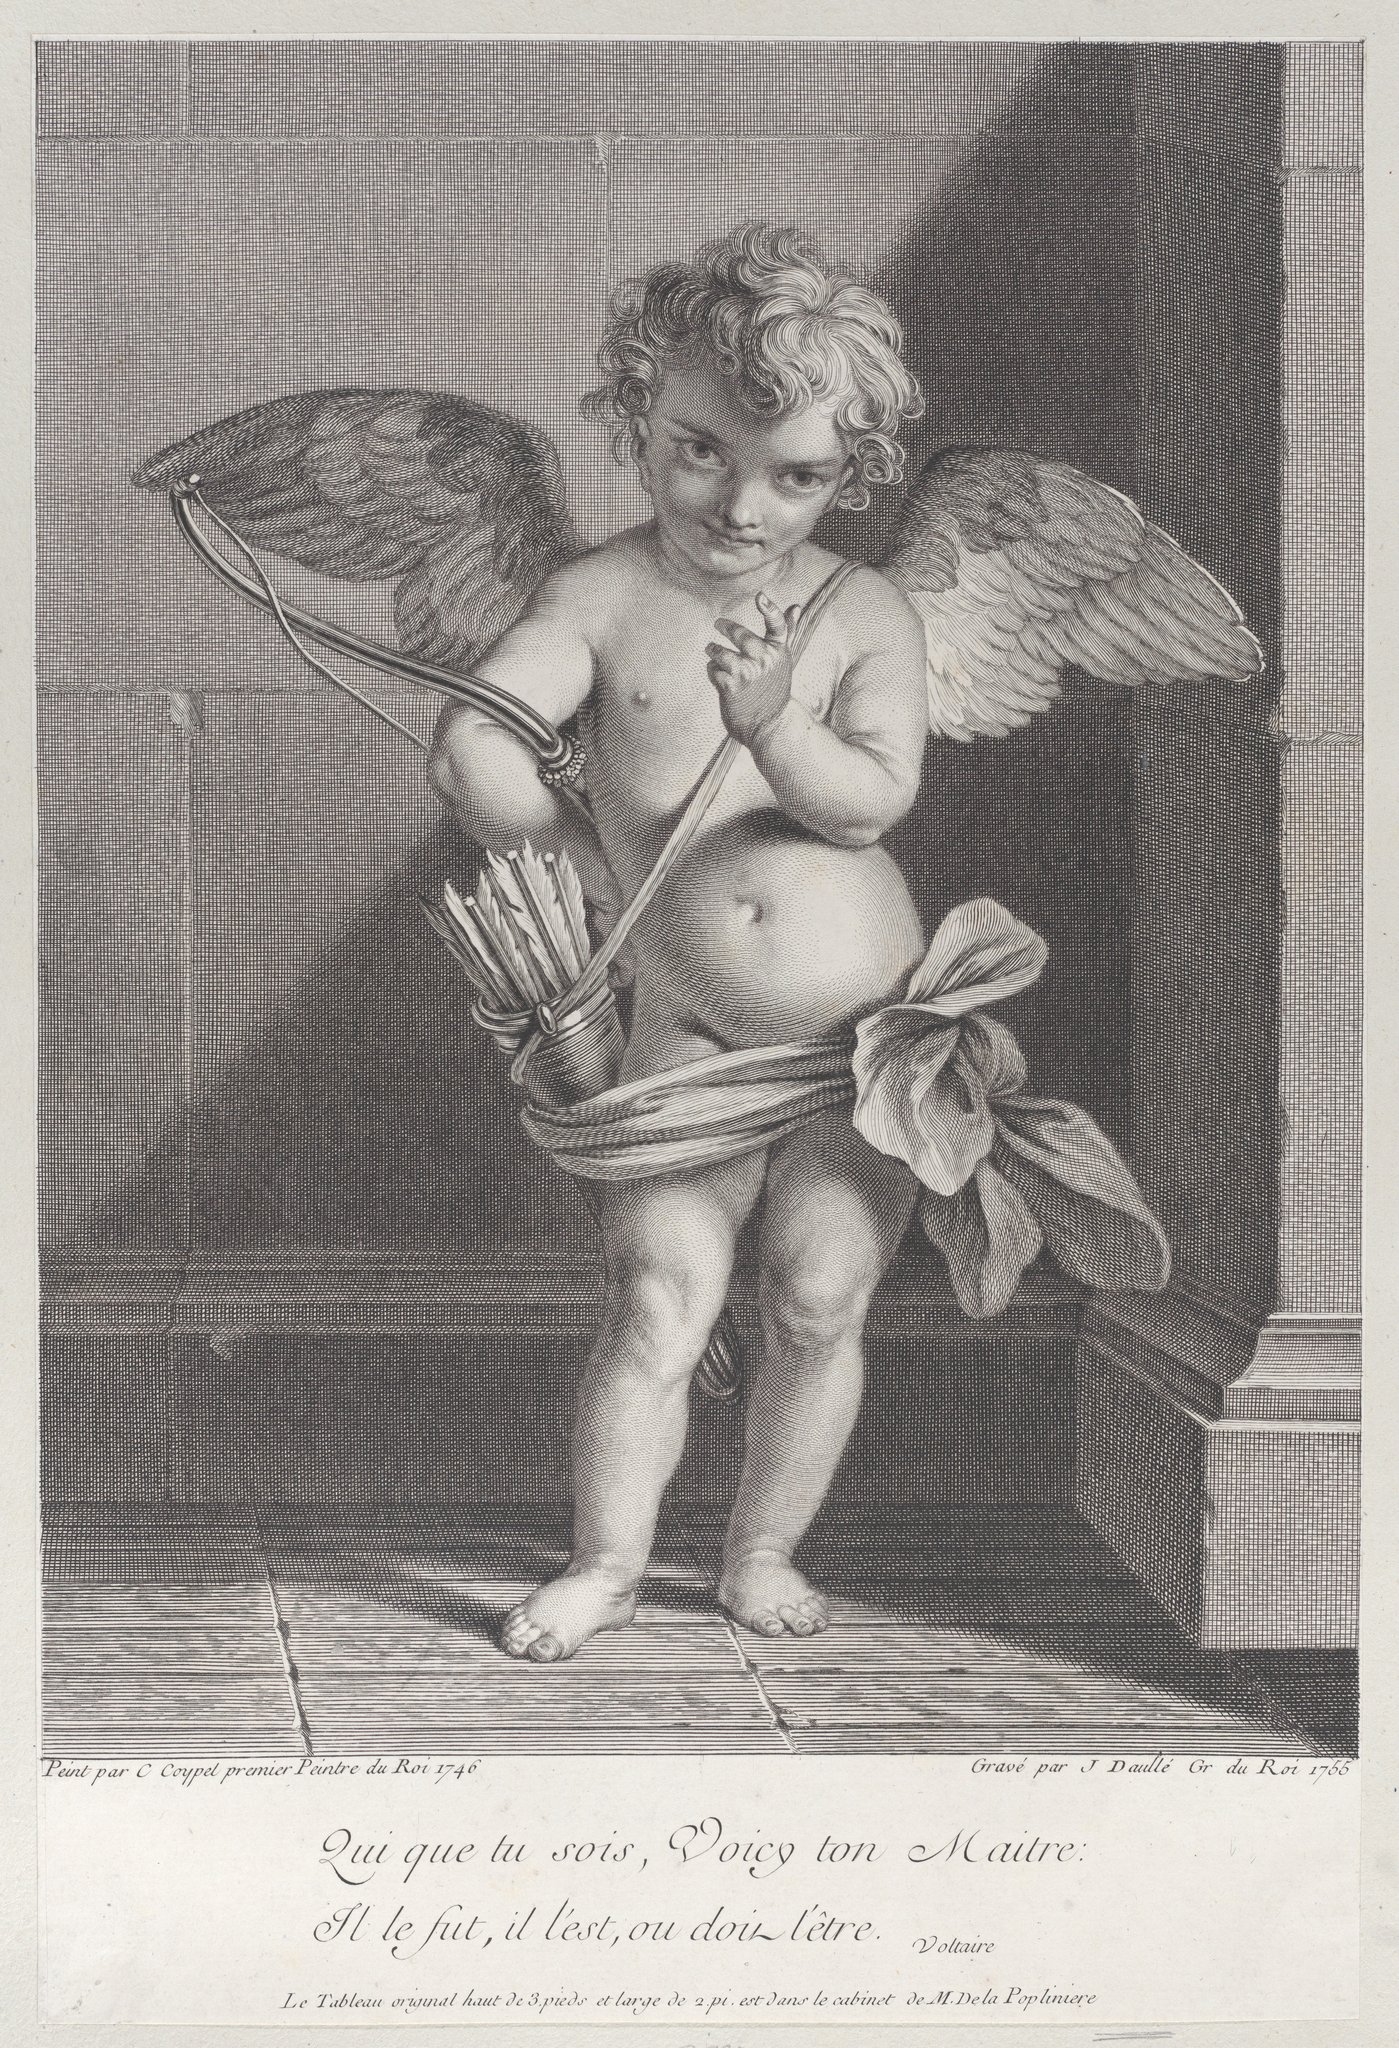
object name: print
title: Cupid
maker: jean daullé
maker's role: artist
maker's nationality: french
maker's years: 1703-1763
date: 1755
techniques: engraving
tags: cupid